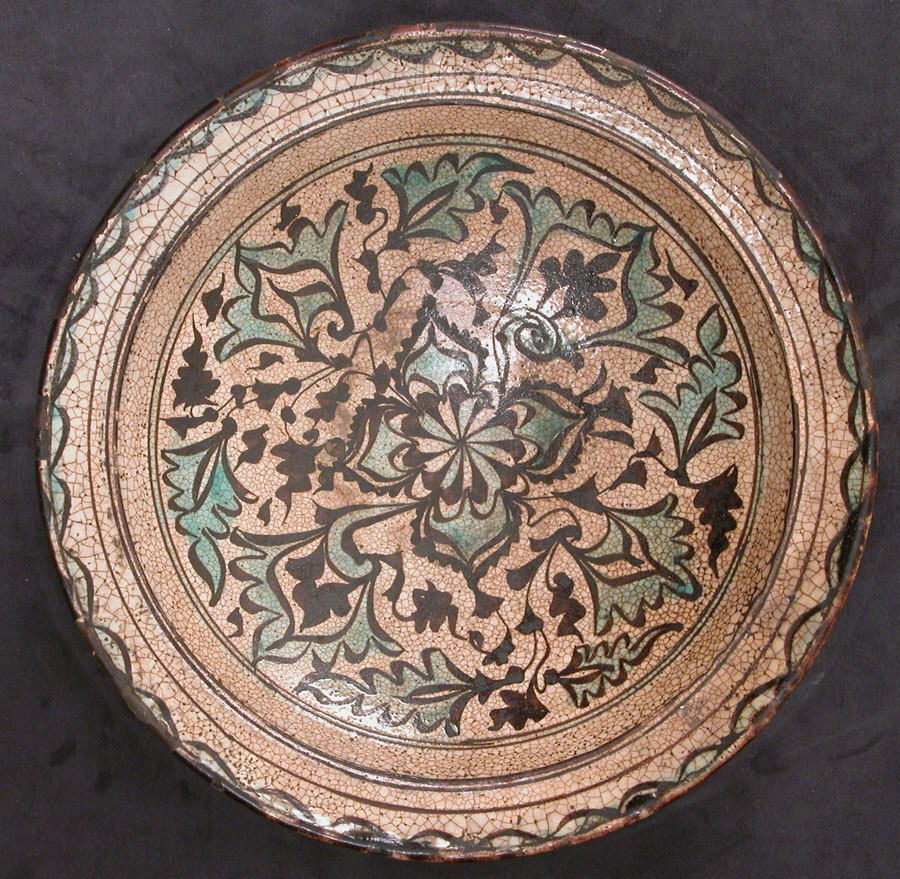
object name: dish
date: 1401-1600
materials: clay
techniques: glazing, painting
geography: central asia